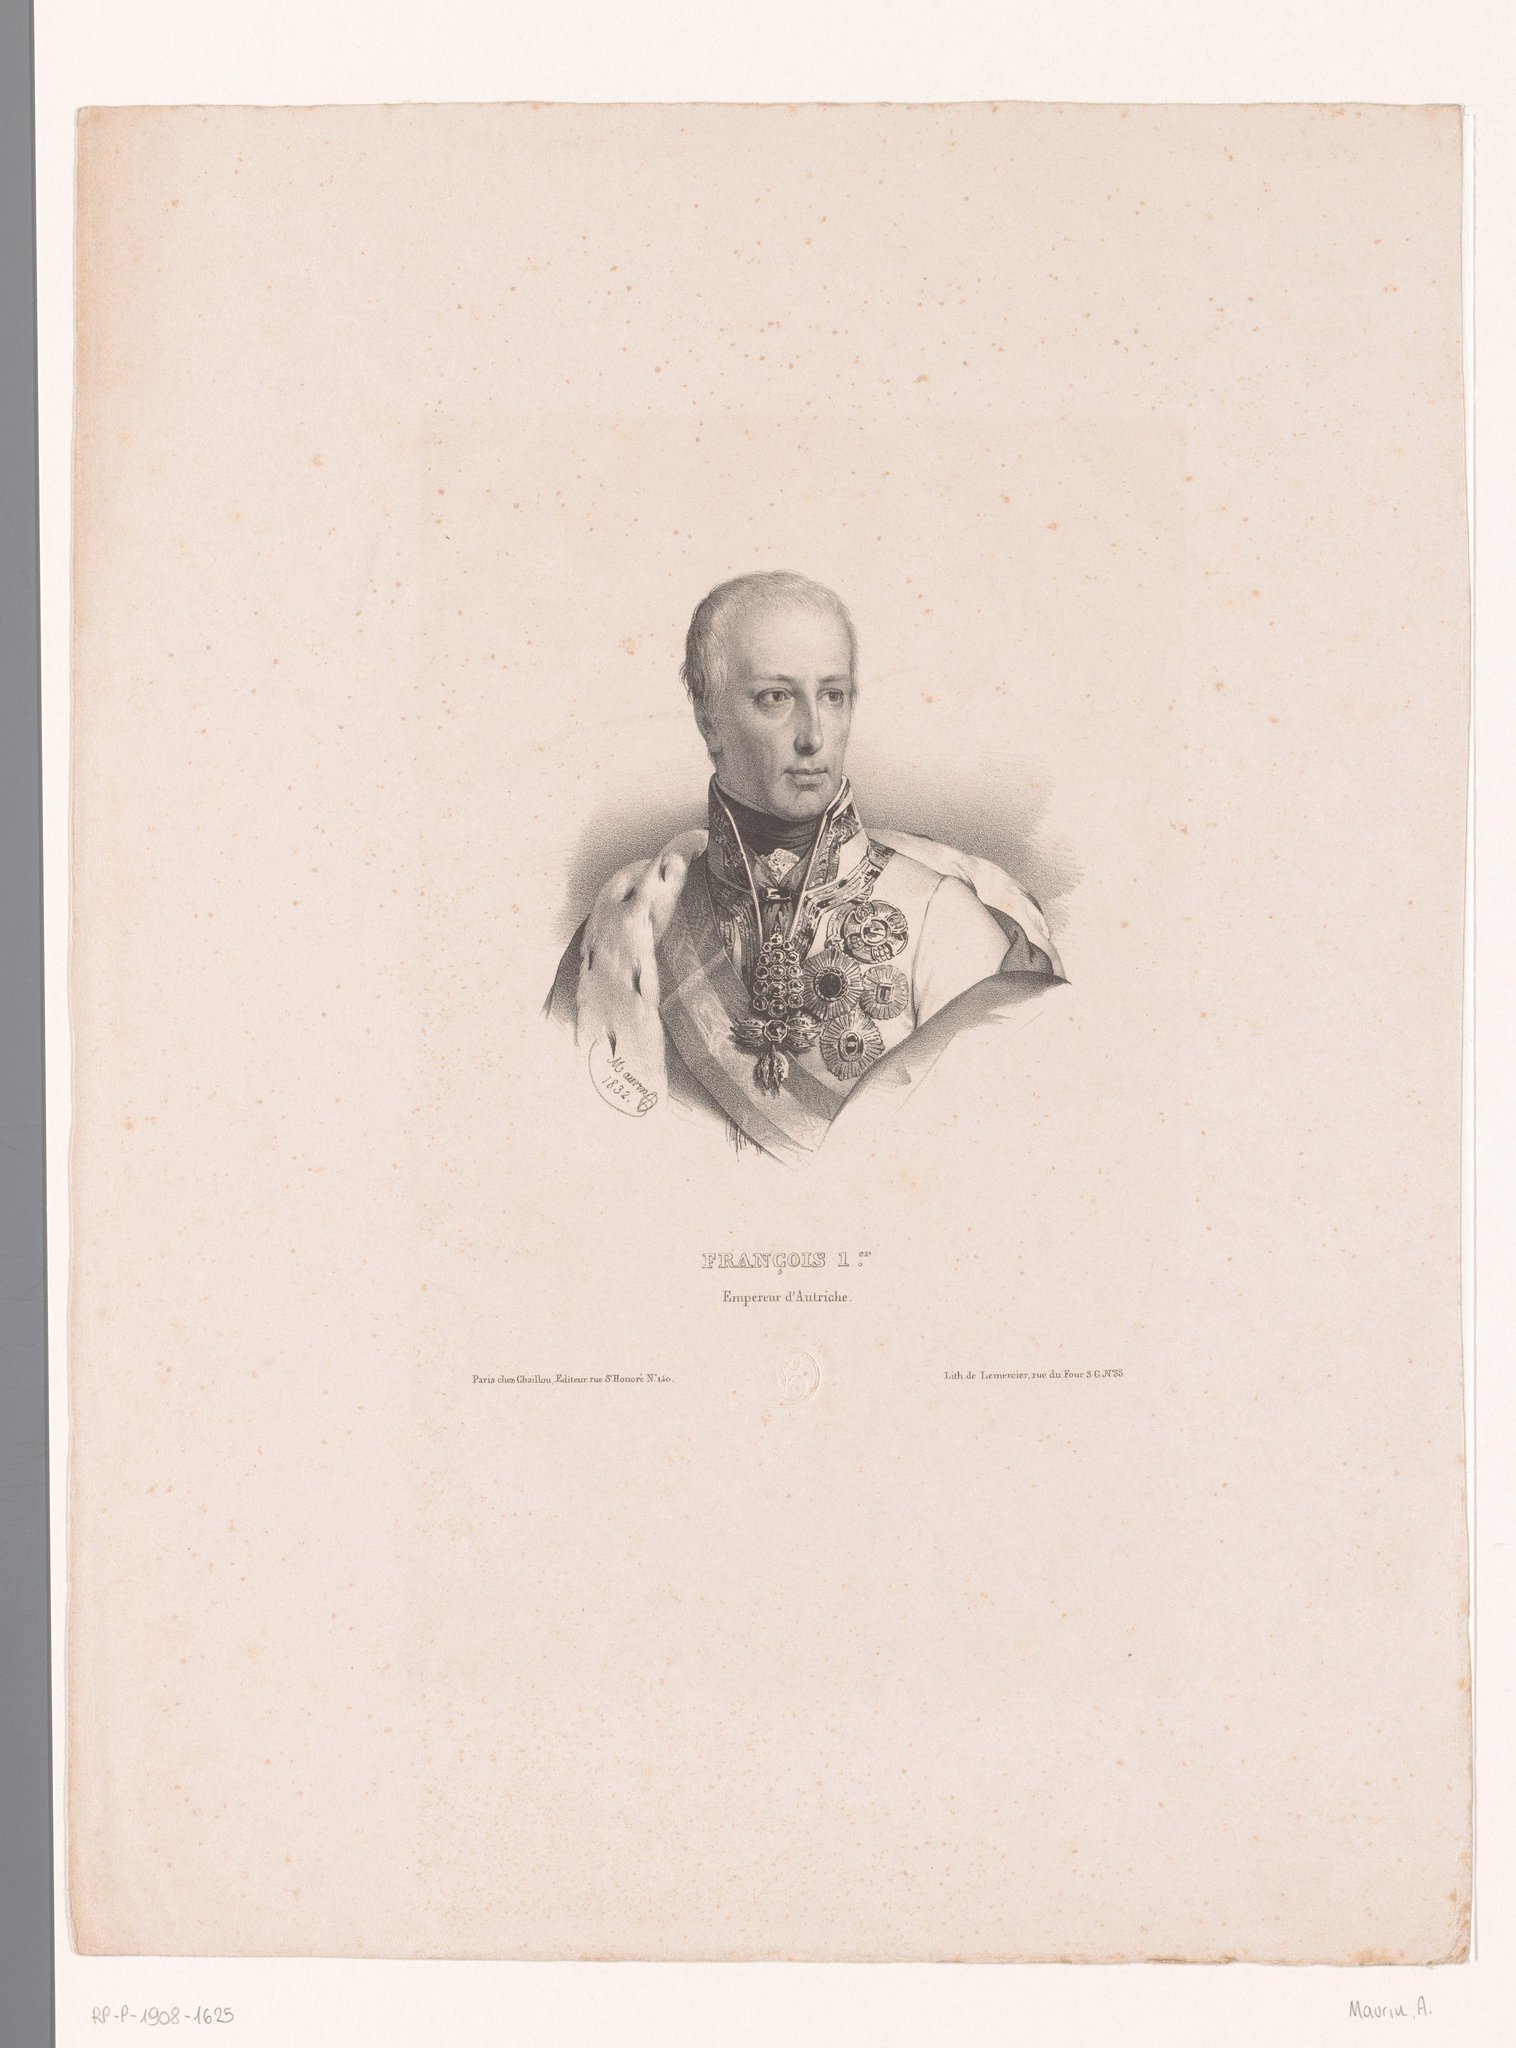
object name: print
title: François 1er. empereur d'Autriche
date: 1832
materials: paper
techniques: lithograph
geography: paris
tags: vienna, frans ii (rooms-duits keizer), historical persons, emperor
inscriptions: collector's mark: Lugt 2228, check stamp: Lugt 619